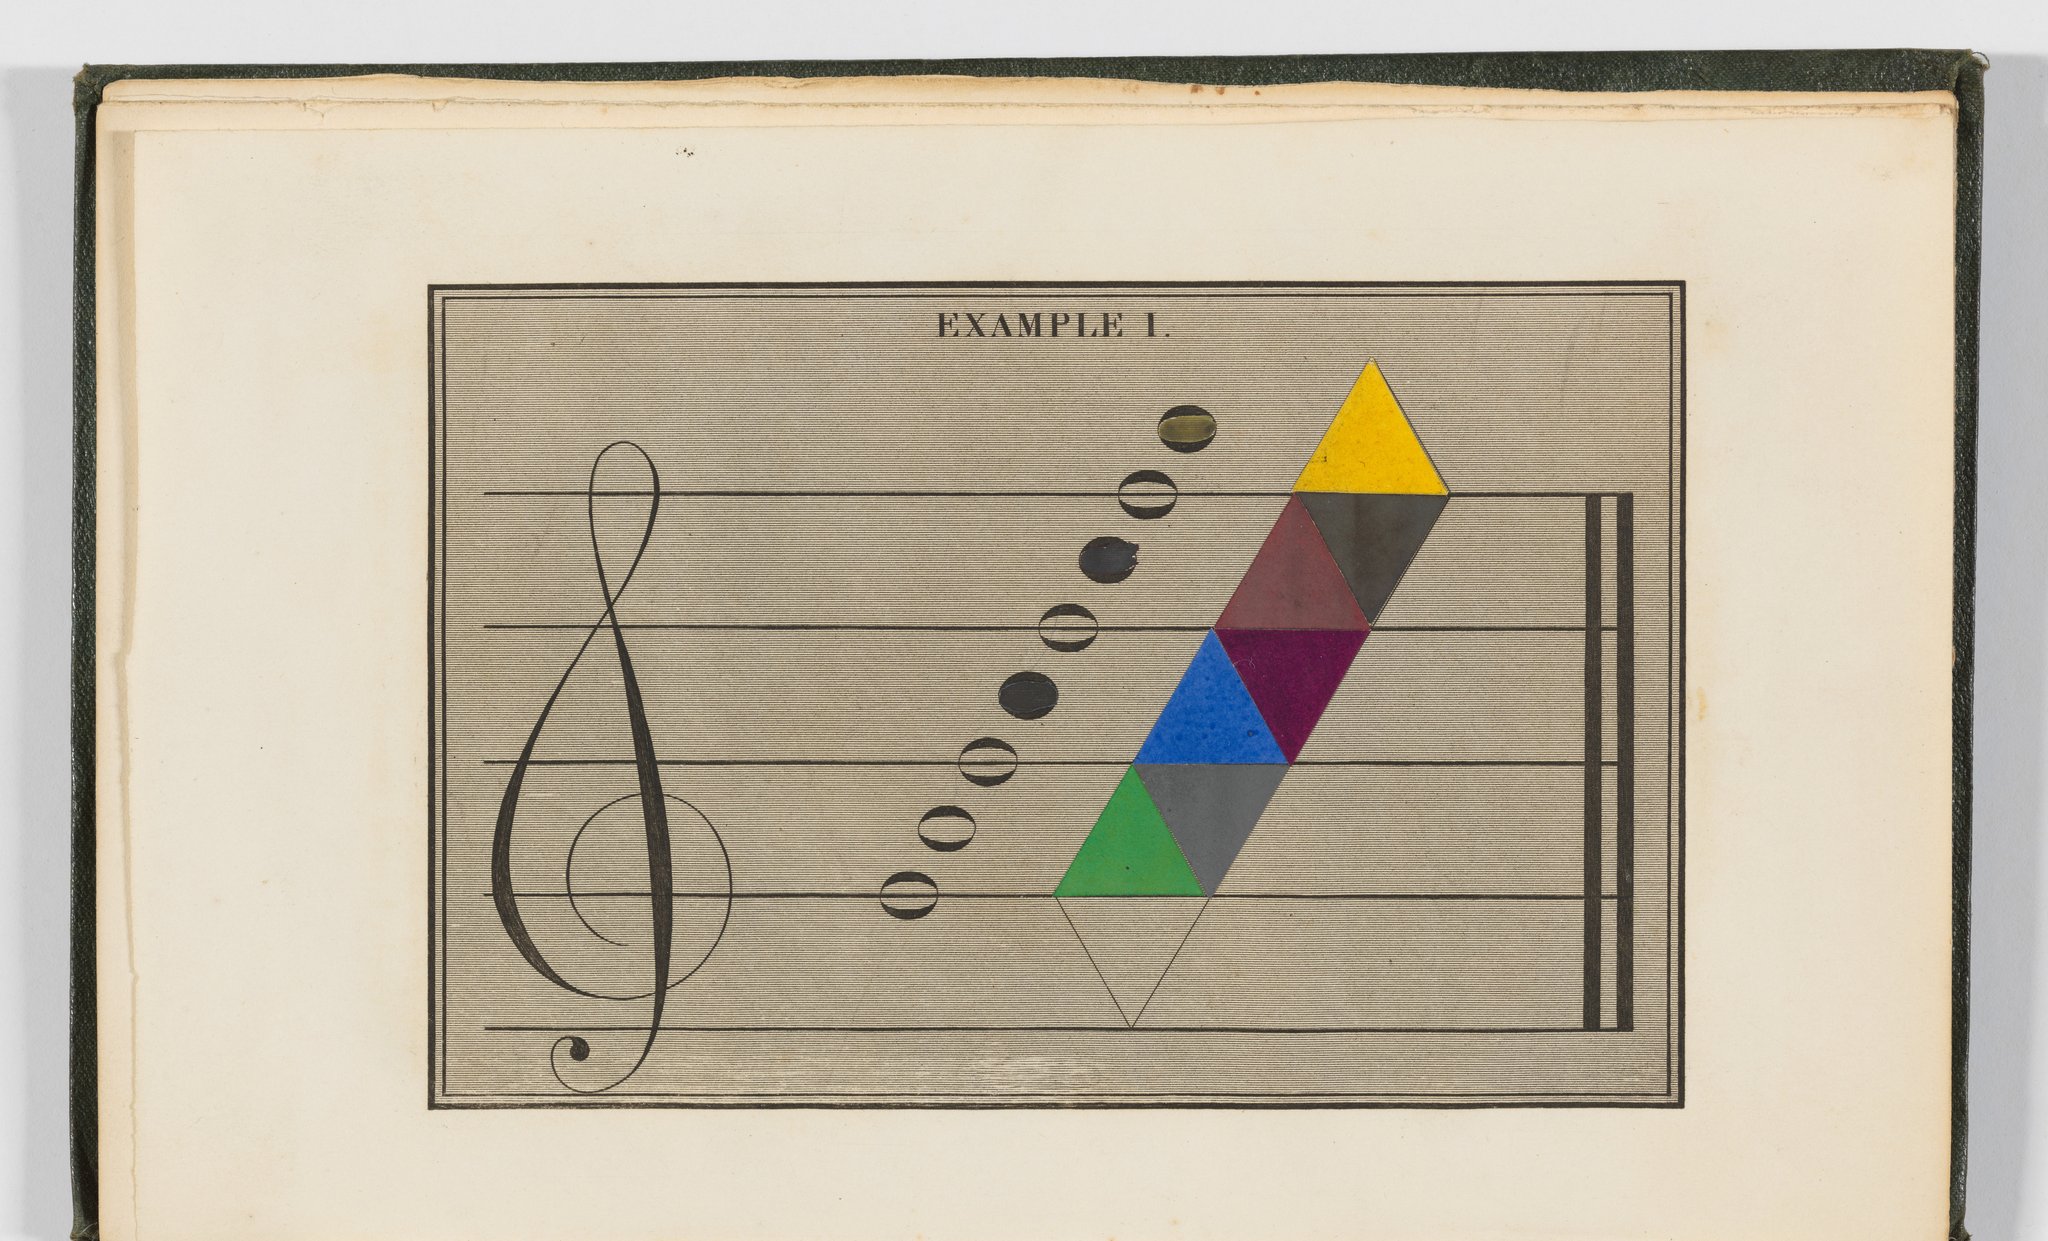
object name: book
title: The Laws of Harmonious Colouring, adapted to Interior Decorations, Manufactures, and other Useful Purposes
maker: david ramsay hay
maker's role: author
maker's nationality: british, scottish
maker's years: 1798-1866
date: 1836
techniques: engraving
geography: england